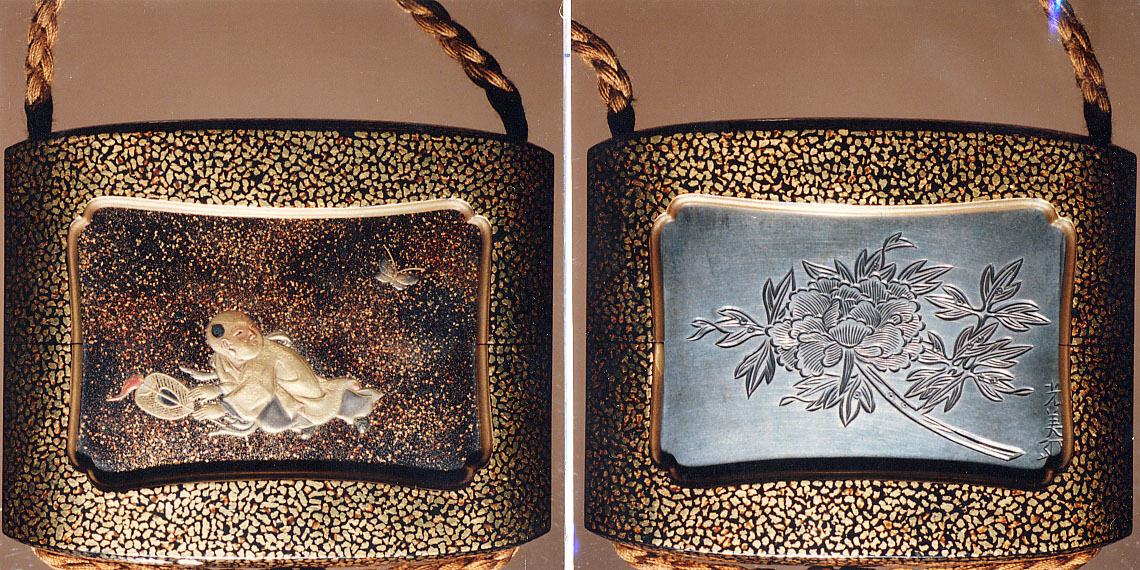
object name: inrō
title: Case (Inrō) with Design of Chinese Child (obverse); Silver Pill Box with Peony (reverse)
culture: japanese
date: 1801-1900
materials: gold, lacquer, metal, silver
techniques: roiro, maki-e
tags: children,peonies